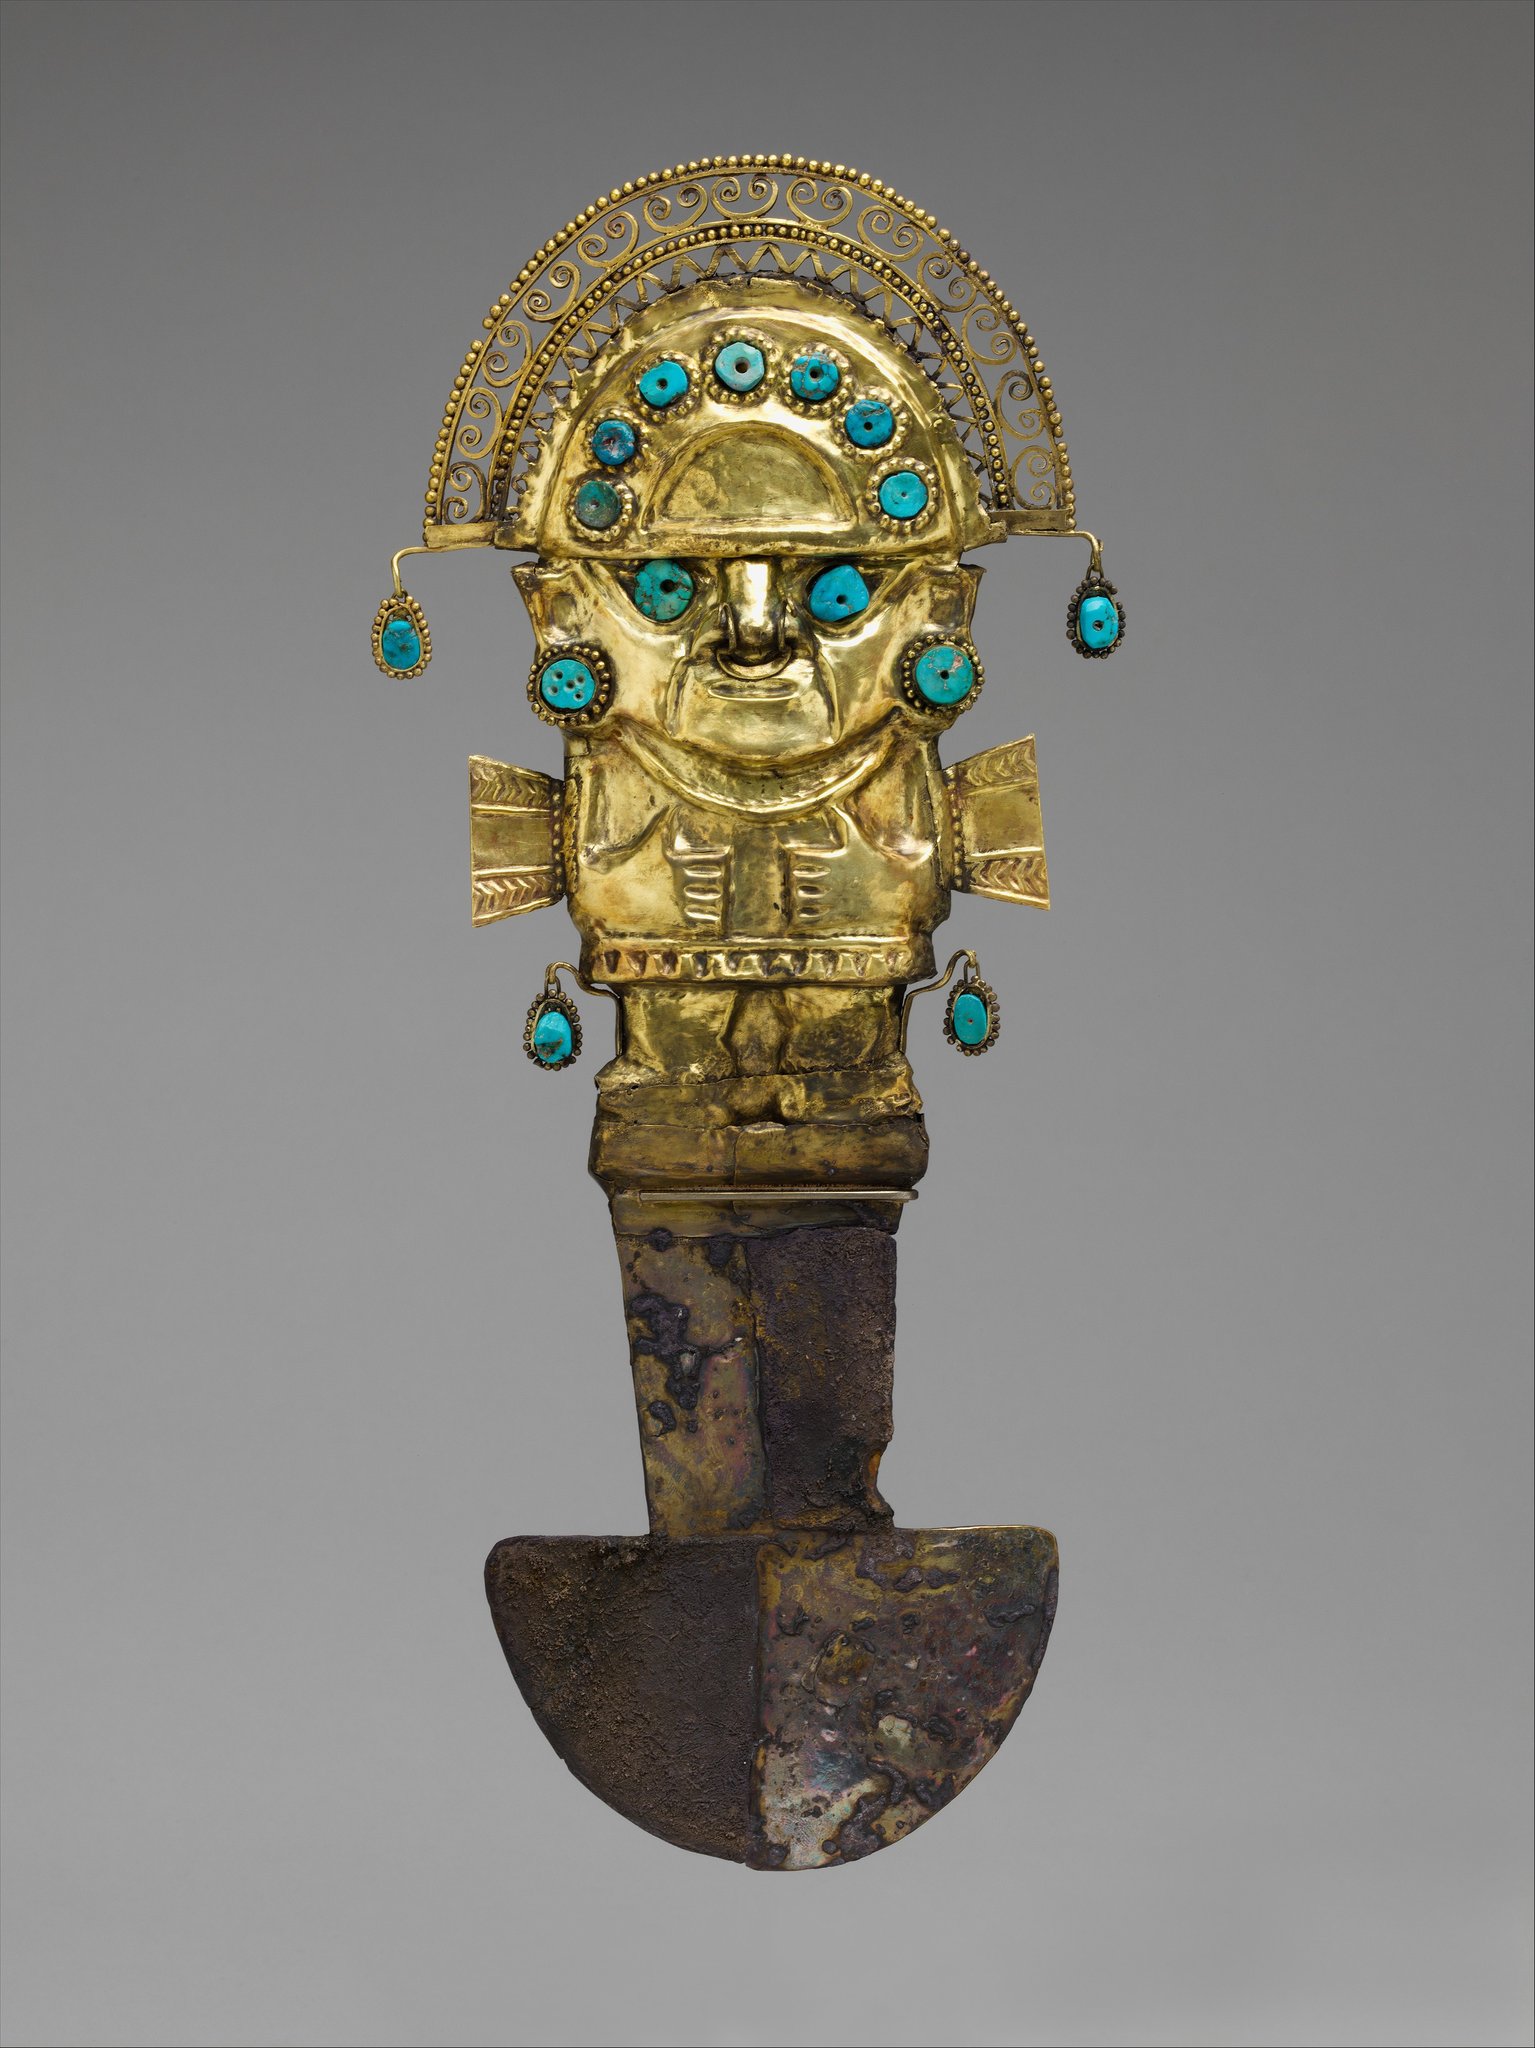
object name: knife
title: Tumi (knife)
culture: lambayeque, sicán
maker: lambayeque (sicán) artist(s)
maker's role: artist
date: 900-1100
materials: gold, silver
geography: peru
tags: deities